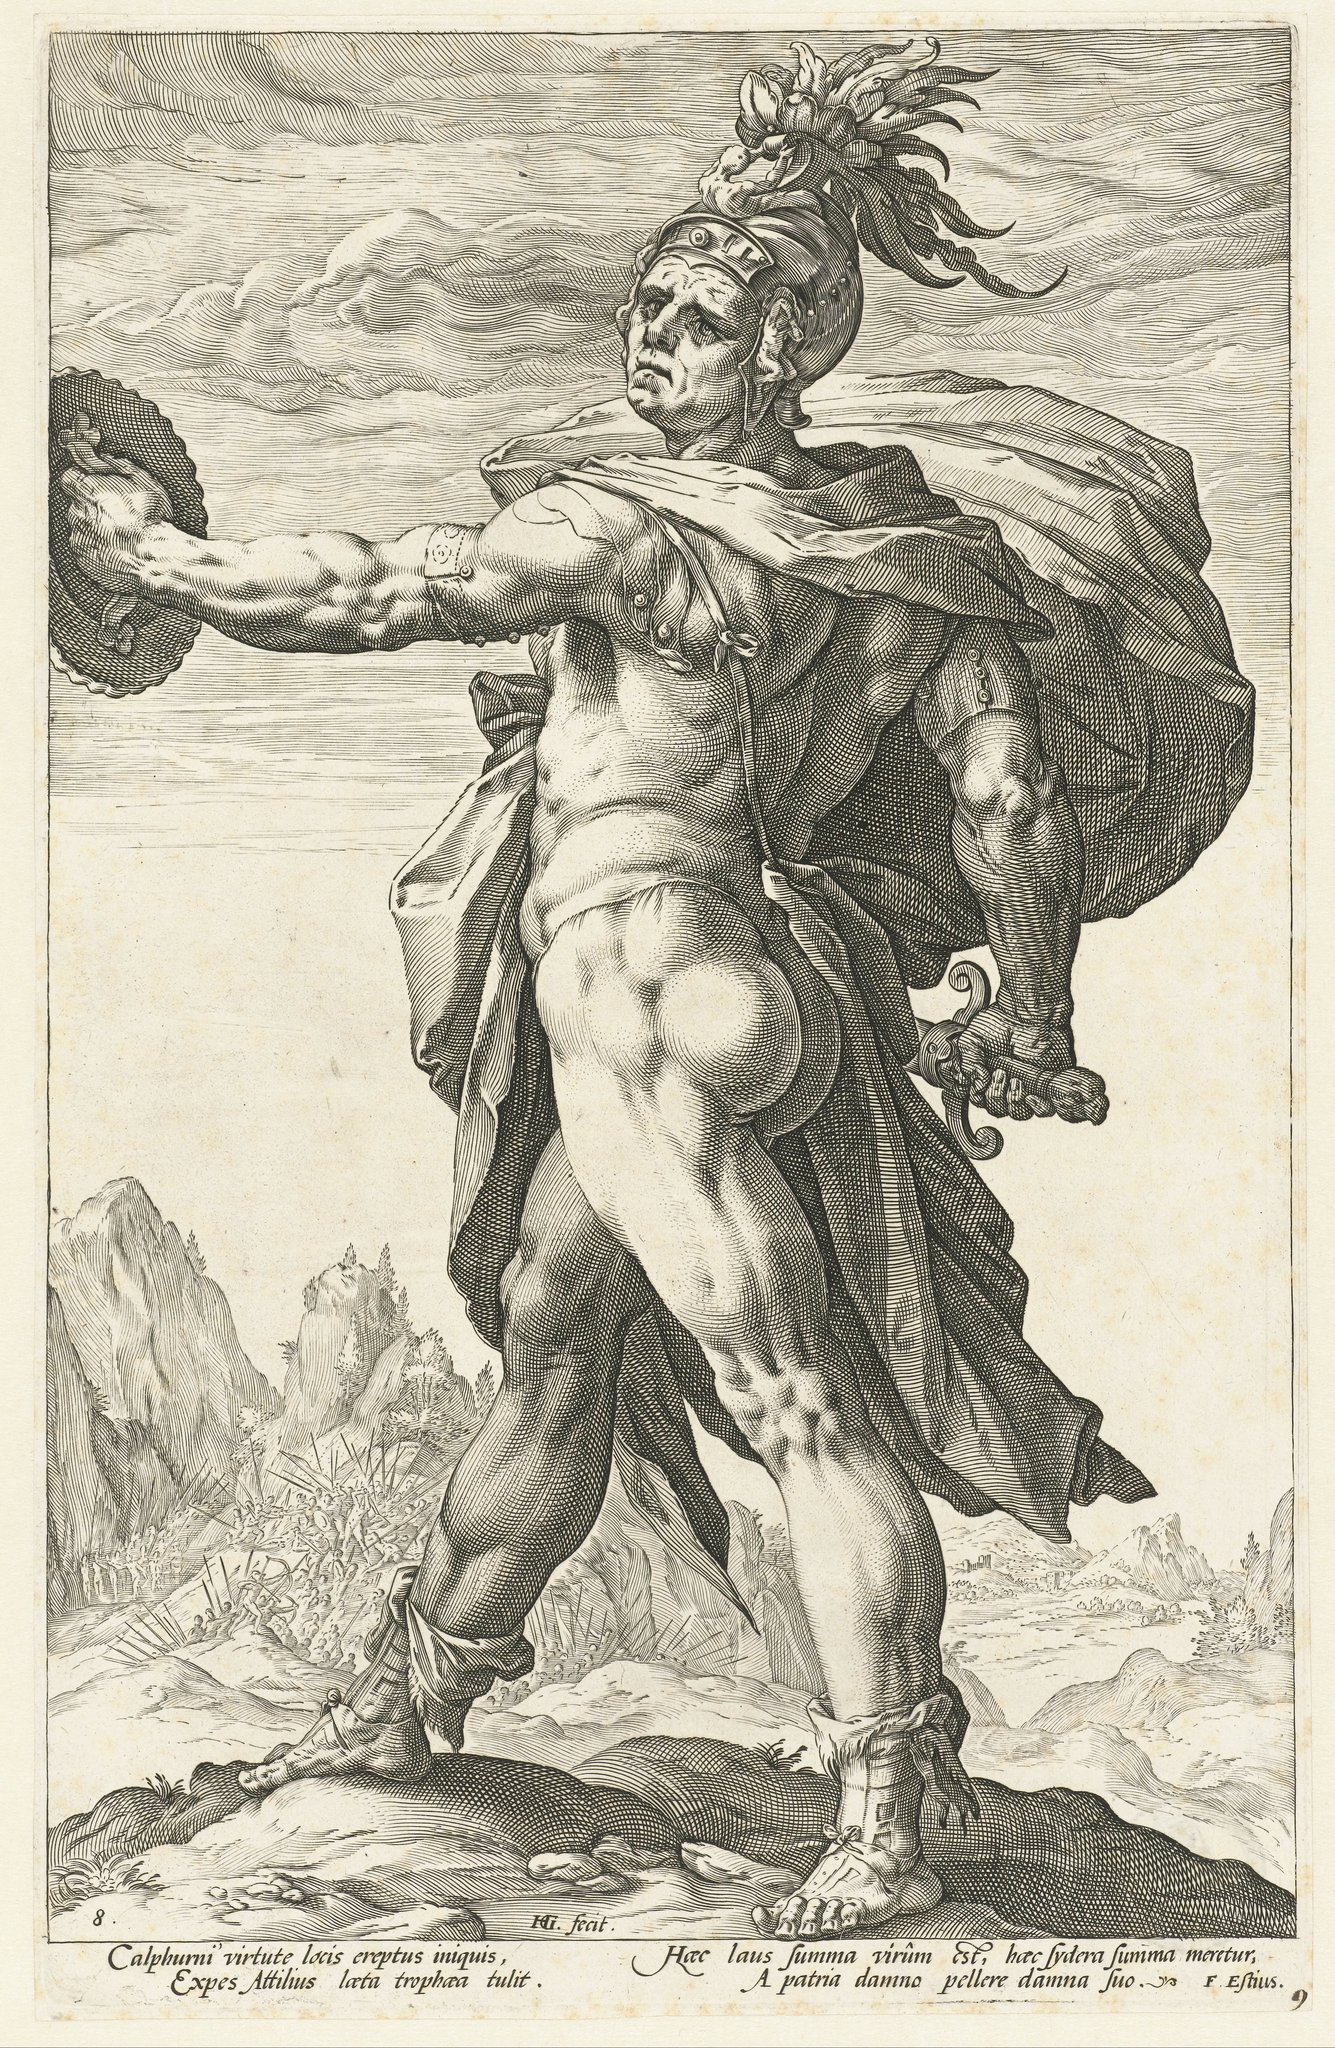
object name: print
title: De Romeinse helden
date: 1586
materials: paper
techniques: engraving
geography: haarlem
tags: male persons from classical history (calpurnius, m.)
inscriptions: collector's mark: Lugt 11, collector's mark: Lugt 10, collector's mark: ‘Hinloopen’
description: De held Marcus Calpurnius Flama ten voeten uit, op de linkerzijde gezien. Op de achtergrond is te zien hoe hij met een klein leger consul Attilius Calatinus redde uit een hinderlaag. Onder de voorstelling twee maal twee versregels in Latijn. Deze prent is onderdeel van een serie van tien prenten, bestaand uit een ongenummerde titelprent, acht genummerde voorstellingen van helden en een ongenummerde afsluitende prent.